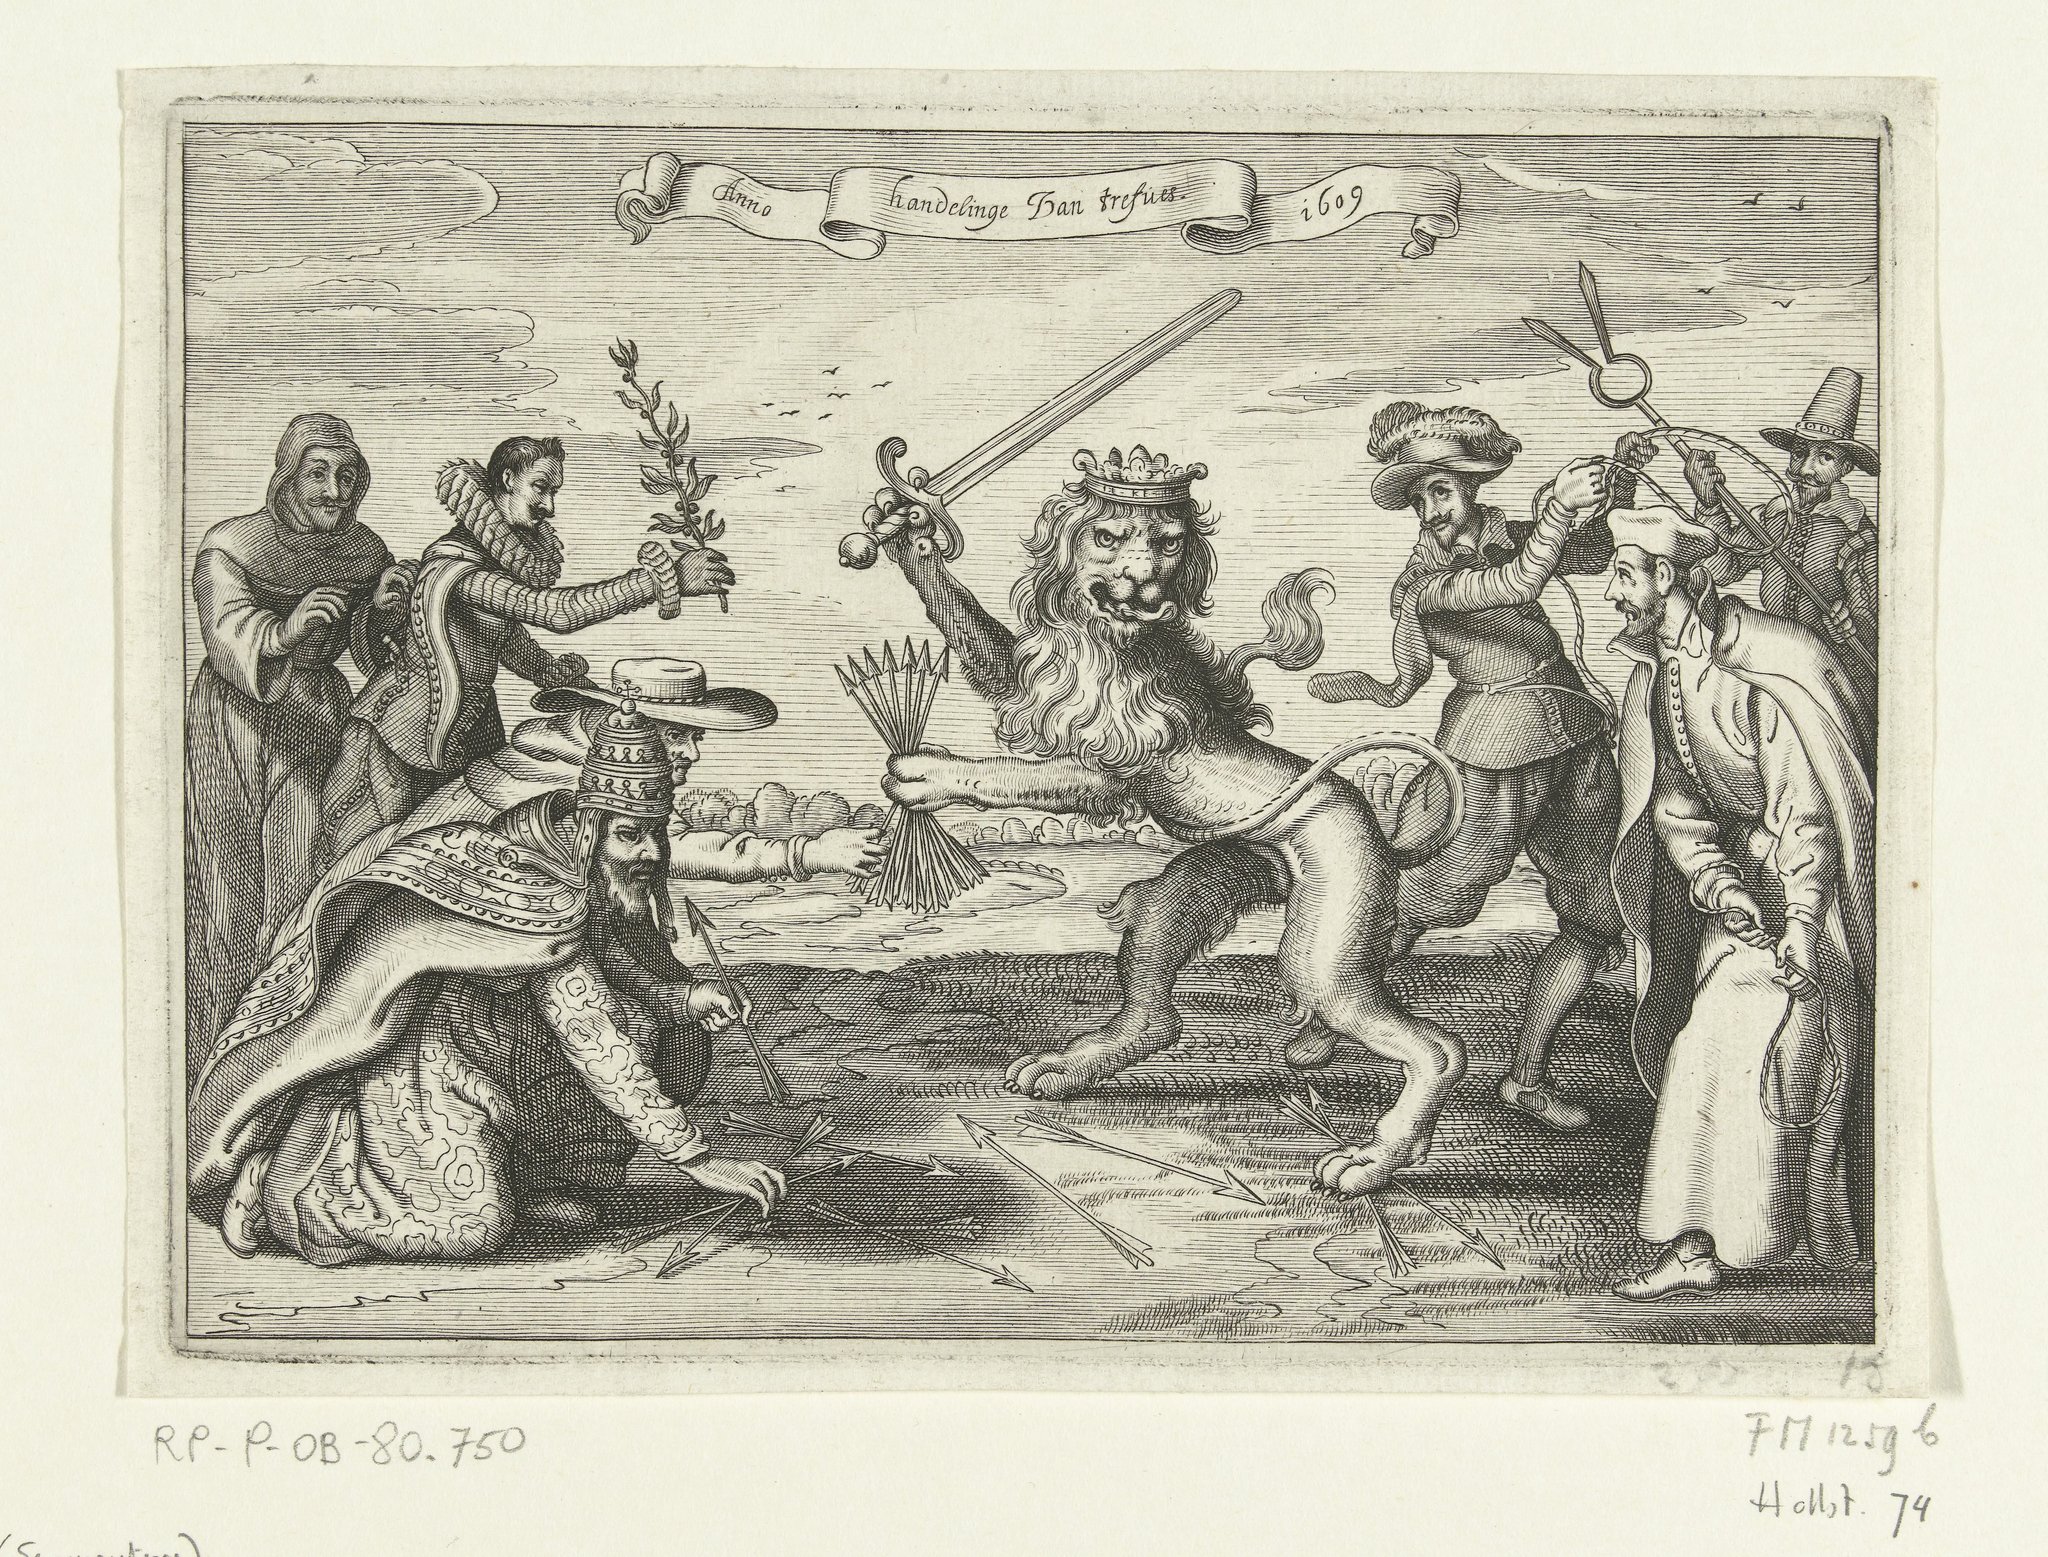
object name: print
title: Allegorie op de vredesonderhandelingen voor het Bestand, 1609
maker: pieter serwouters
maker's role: draughtsman, print maker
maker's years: 1586-1657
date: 1624-1626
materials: paper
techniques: etching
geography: northern netherlands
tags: antwerp, spain, peace negotiations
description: Allegorie op de vredesonderhandelingen voor het Bestand, 1609. De strijdvaardige vrije Nederlandse Leeuw tussen vertegenwoordigers van de Nederlanden nog onder Spaans bestuur, Jan Neyen en Ambrogio Spinola, en vertegenwoordigers van de Roomse kerk (paus, kardinaal, jezuïet). Zonder legenda en onbedrukt op achterzijde..